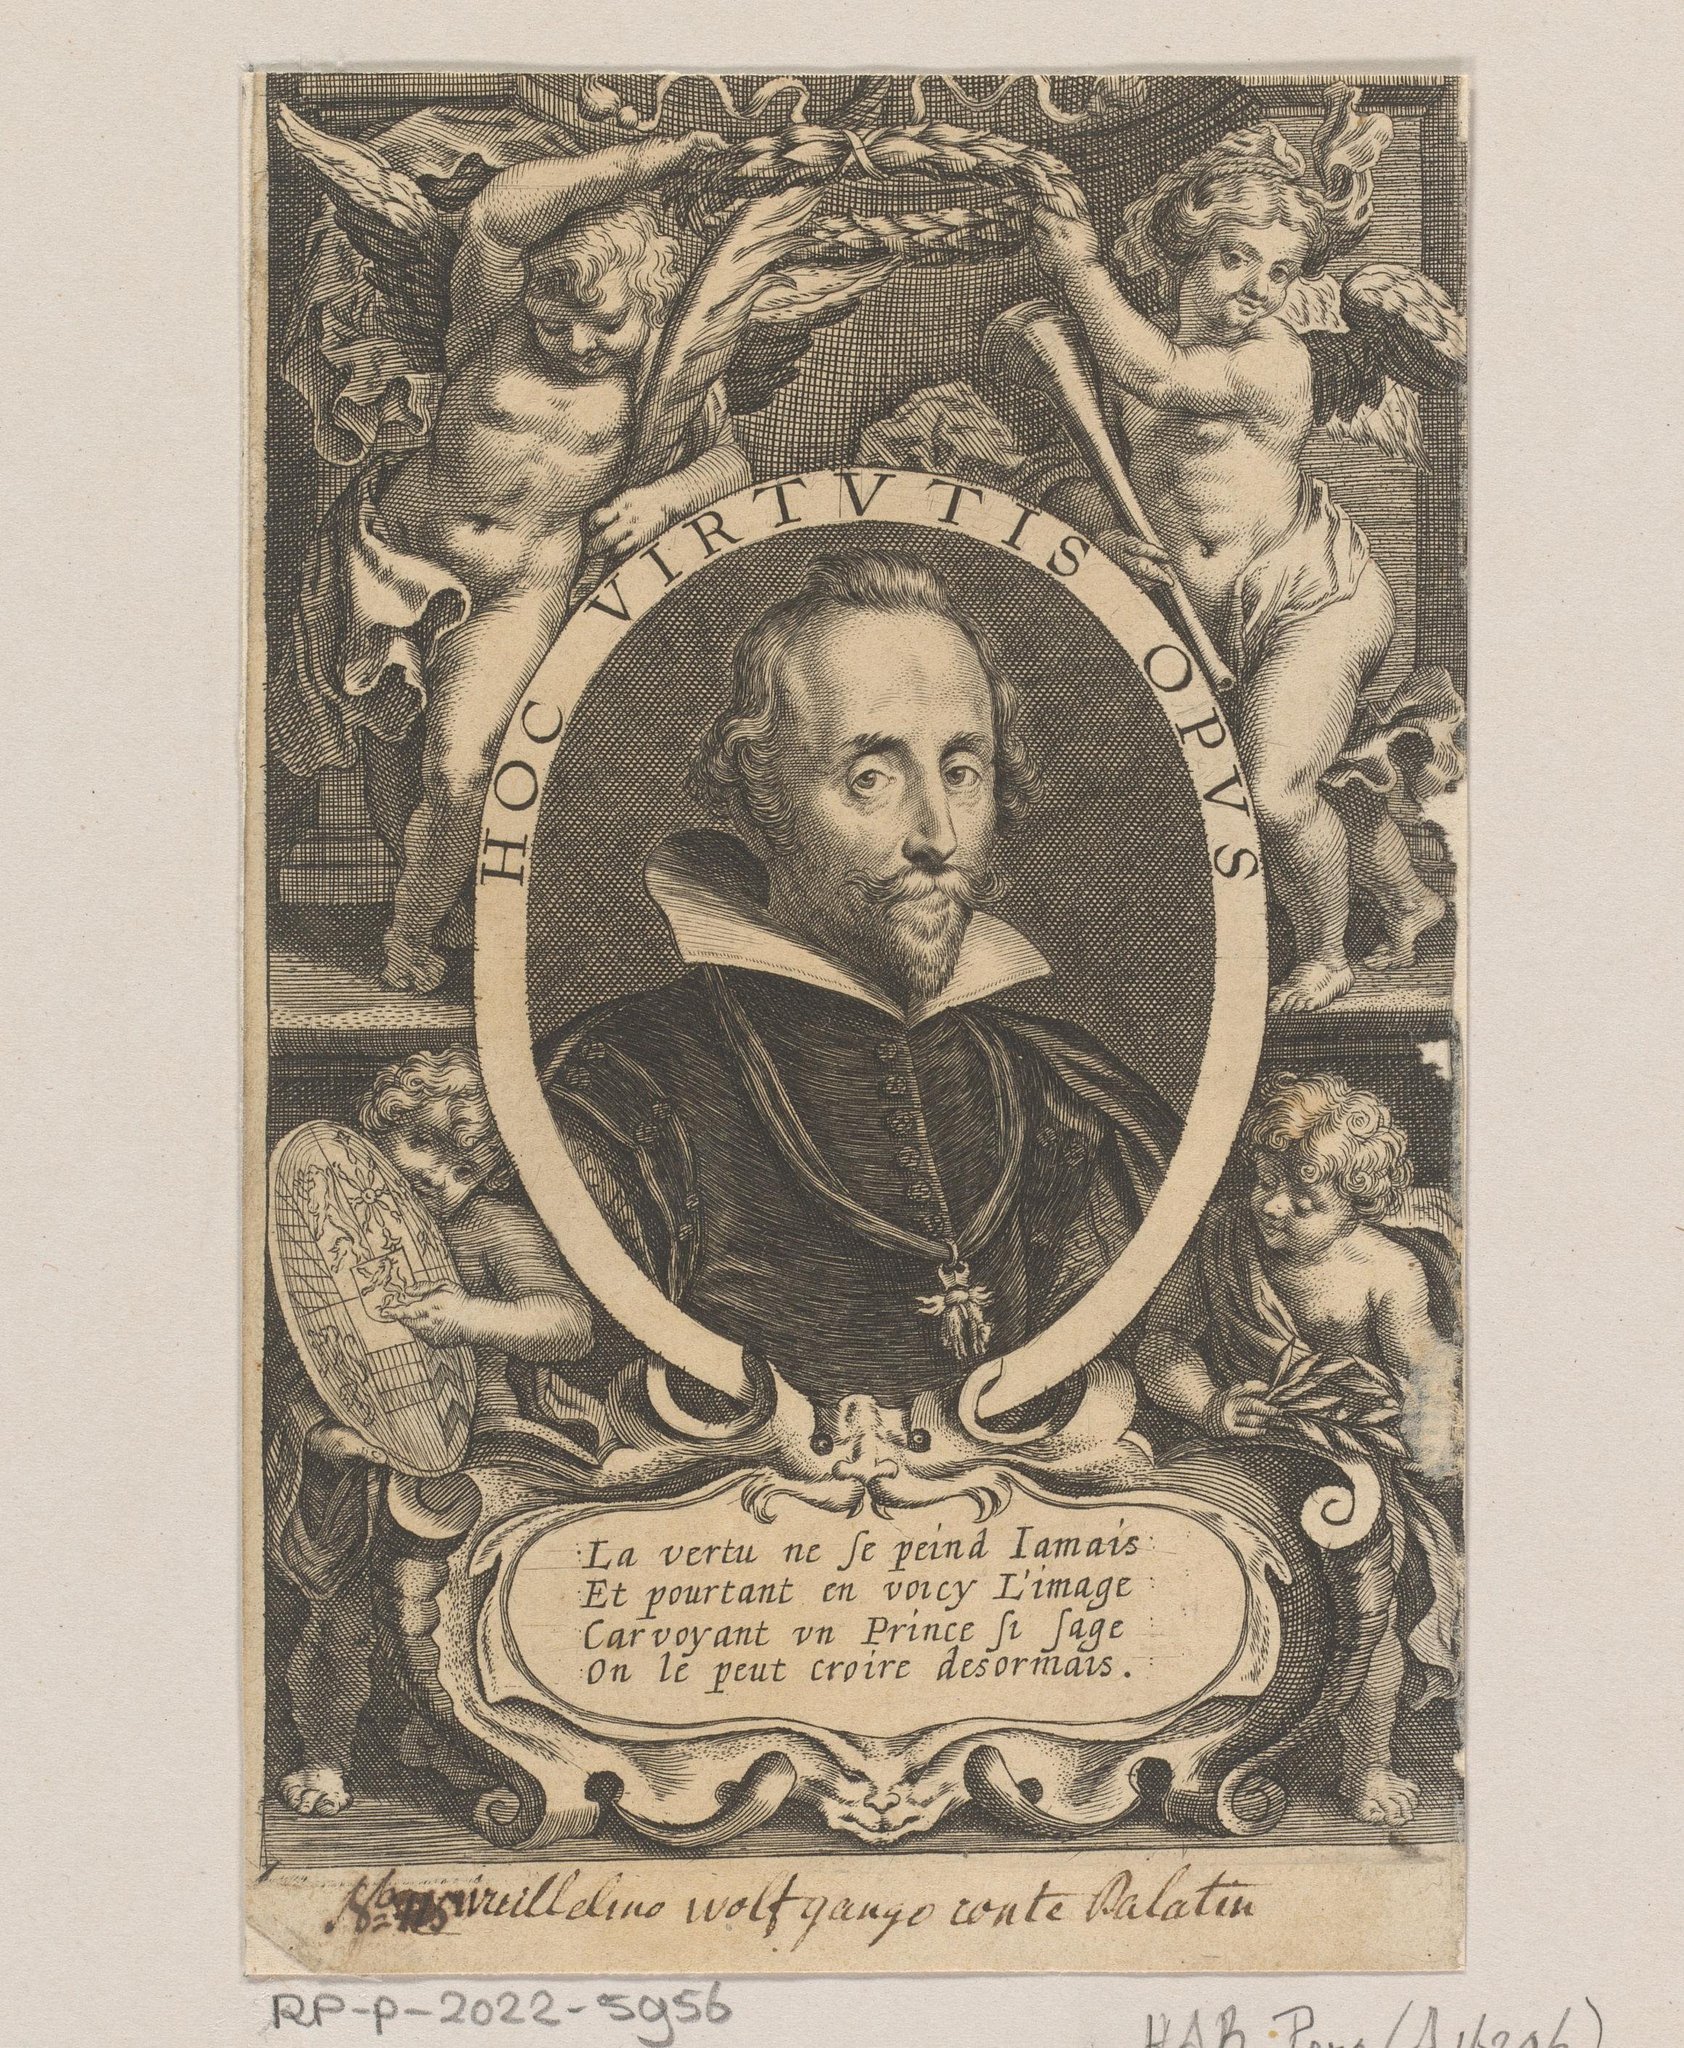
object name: print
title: Portret van Wolfgang Willem van de Palts-Neuburg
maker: Anonymous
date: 1630-1699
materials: paper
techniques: engraving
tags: wolfgang willem van de palts-neuburg, historical persons, knighthood order of the golden fleece, ruler, sovereign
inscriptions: inscription: ‘[...]ireillelino wolfgango conte Palatin’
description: Met vierregelig onderschrift in het Frans en tekst in het Latijn rondom het portret.